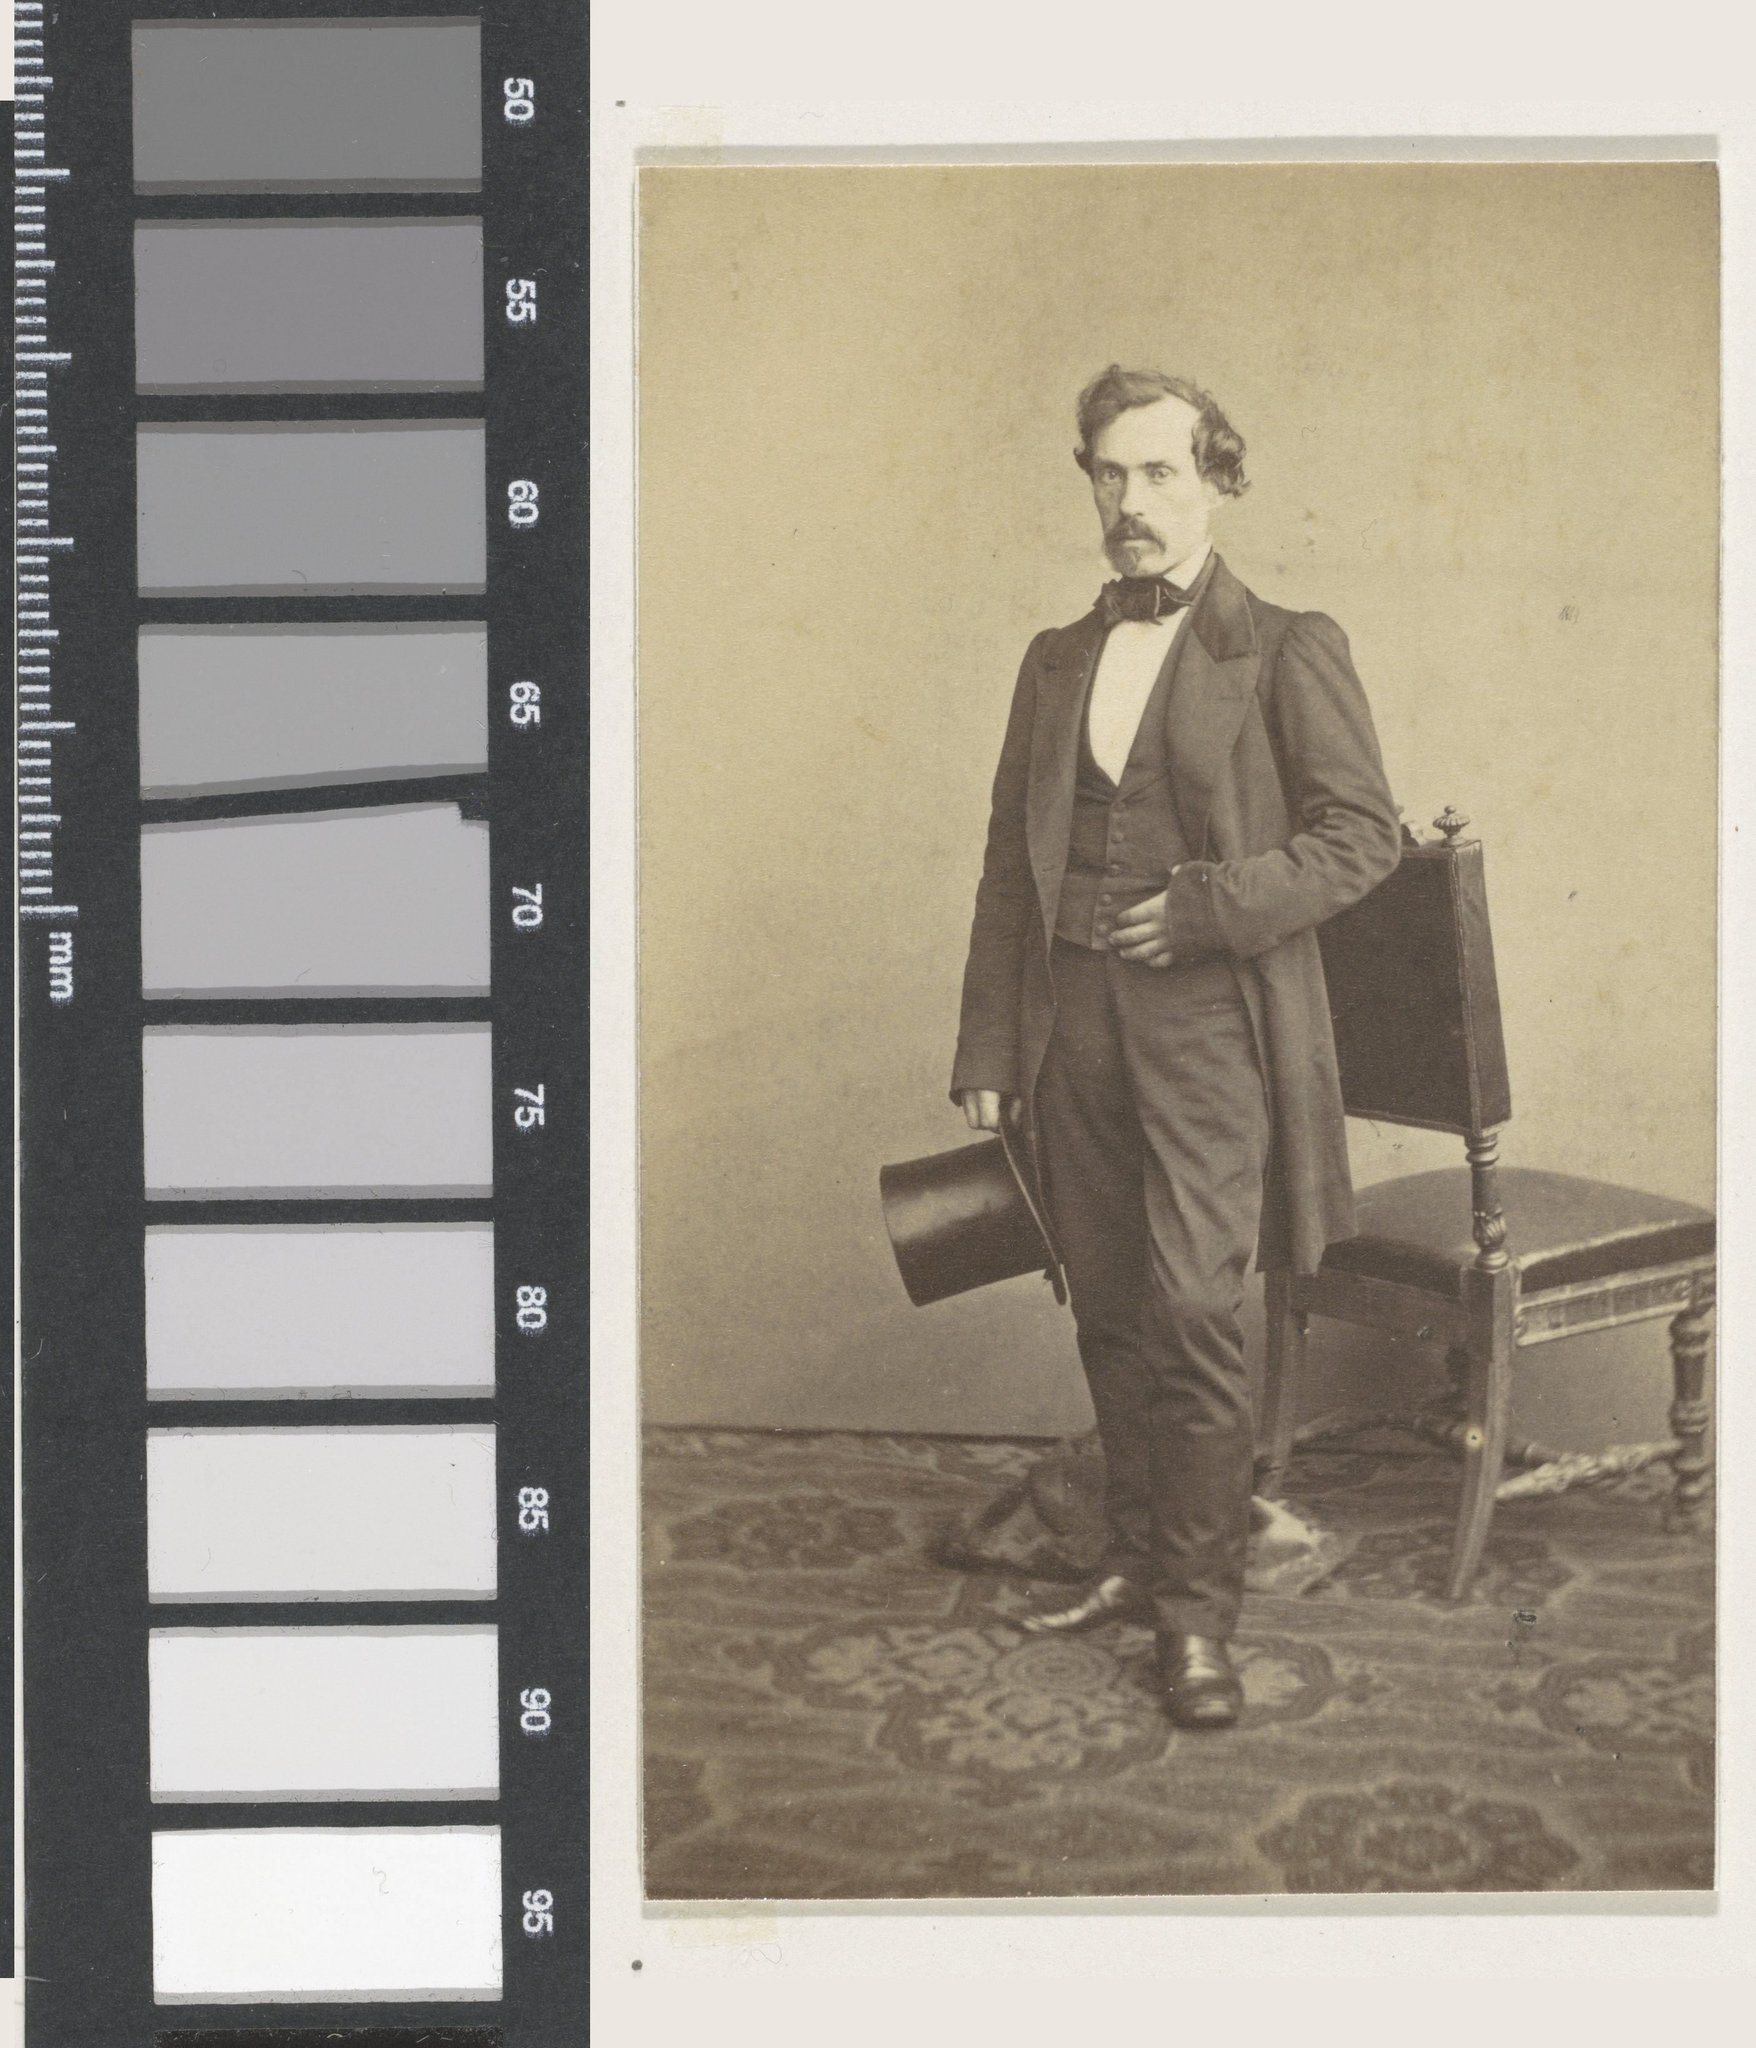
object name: carte de visite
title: L'École d'Anvers. Portraits biographies cartes de visite. Collection Dupont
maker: joseph dupont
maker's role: fotograaf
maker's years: 1818-1901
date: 1861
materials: cardboard, paper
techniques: albumen print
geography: antwerp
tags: henry brown, historical persons, portrait, self-portrait of artist, portrait, self-portrait of draughtsman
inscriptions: inscription: ‘ETABLISSEMENT PHOTOGRAPHIQUE/ de/ J. DUPONT/ Place de Meir 32/ ANVERS/ Maison fondée en 1853’, inscription: ‘Brown, (H)/ graveur sur bois/ prof: a l'académia/ Royal d'Anvers’